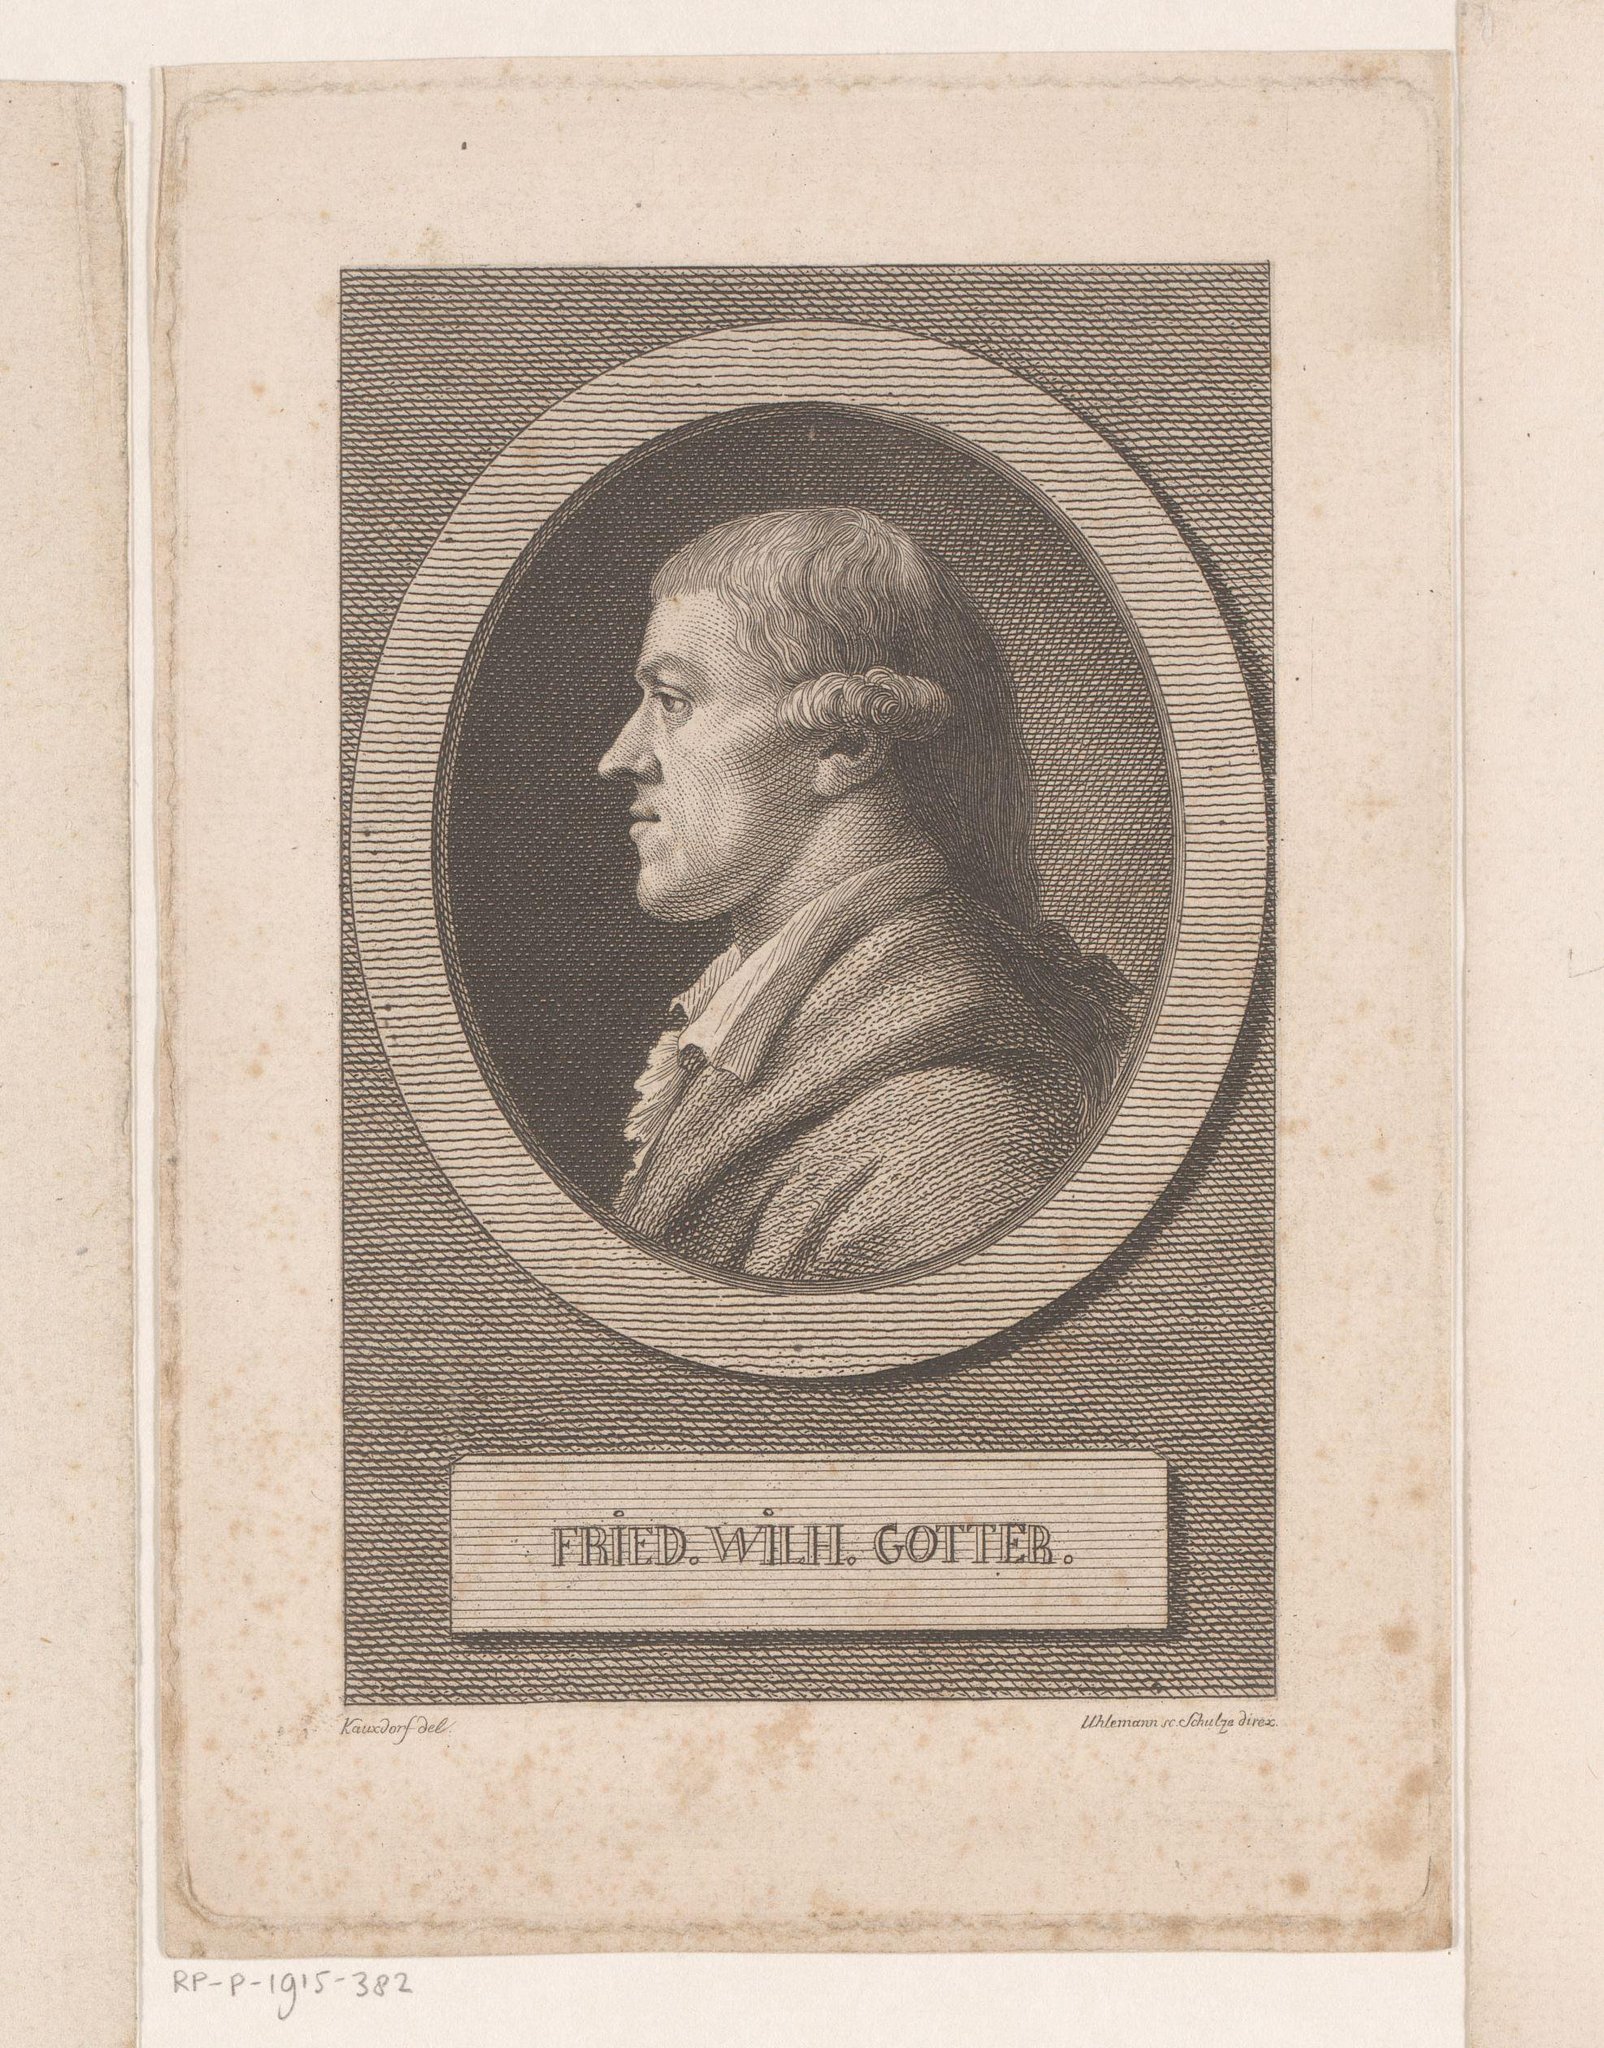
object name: print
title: Portret van Friedrich Wilhelm Gotter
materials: paper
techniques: etching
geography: dresden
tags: historical persons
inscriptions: collector's mark: Lugt 2228